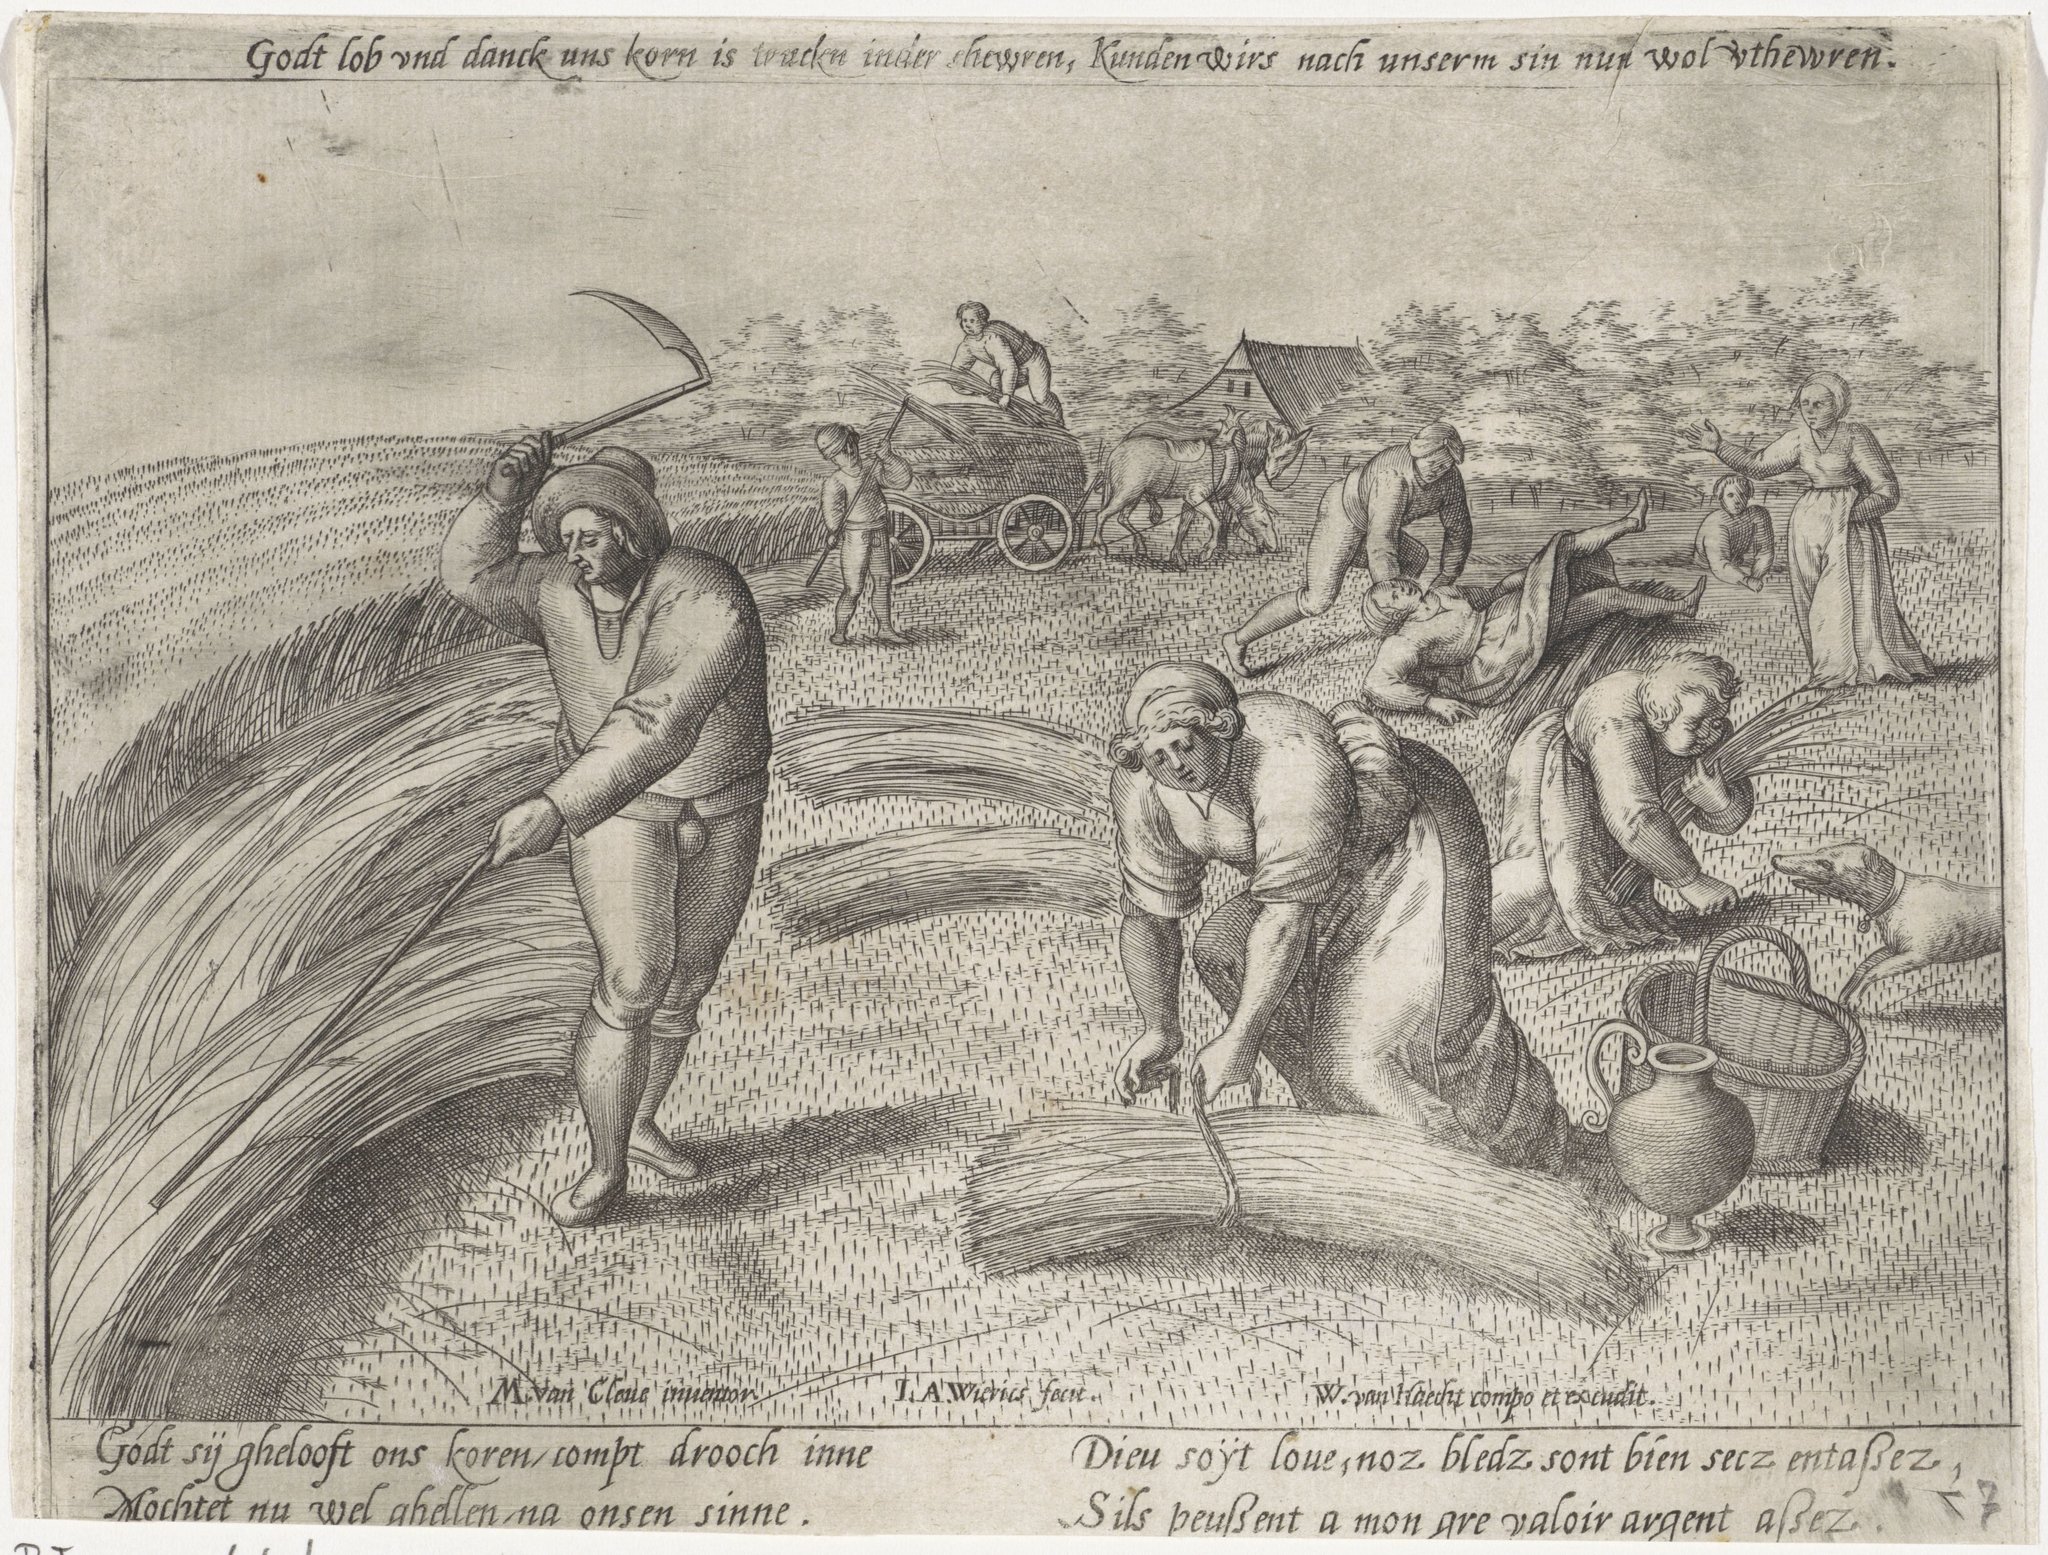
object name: print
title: De oogst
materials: paper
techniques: engraving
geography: antwerp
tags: harvest, rest during harvest (eating, dancing, making love, etc.)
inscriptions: collector's mark: Lugt 2228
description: Mannen en vrouwen aan het werk op de akker. Ze halen de oogst binnen van het land. Op de achtergrond een stel dat door het koren rolt. Op de prent een toelichting op de voorstelling in het Duits, het Nederlands en het Frans.